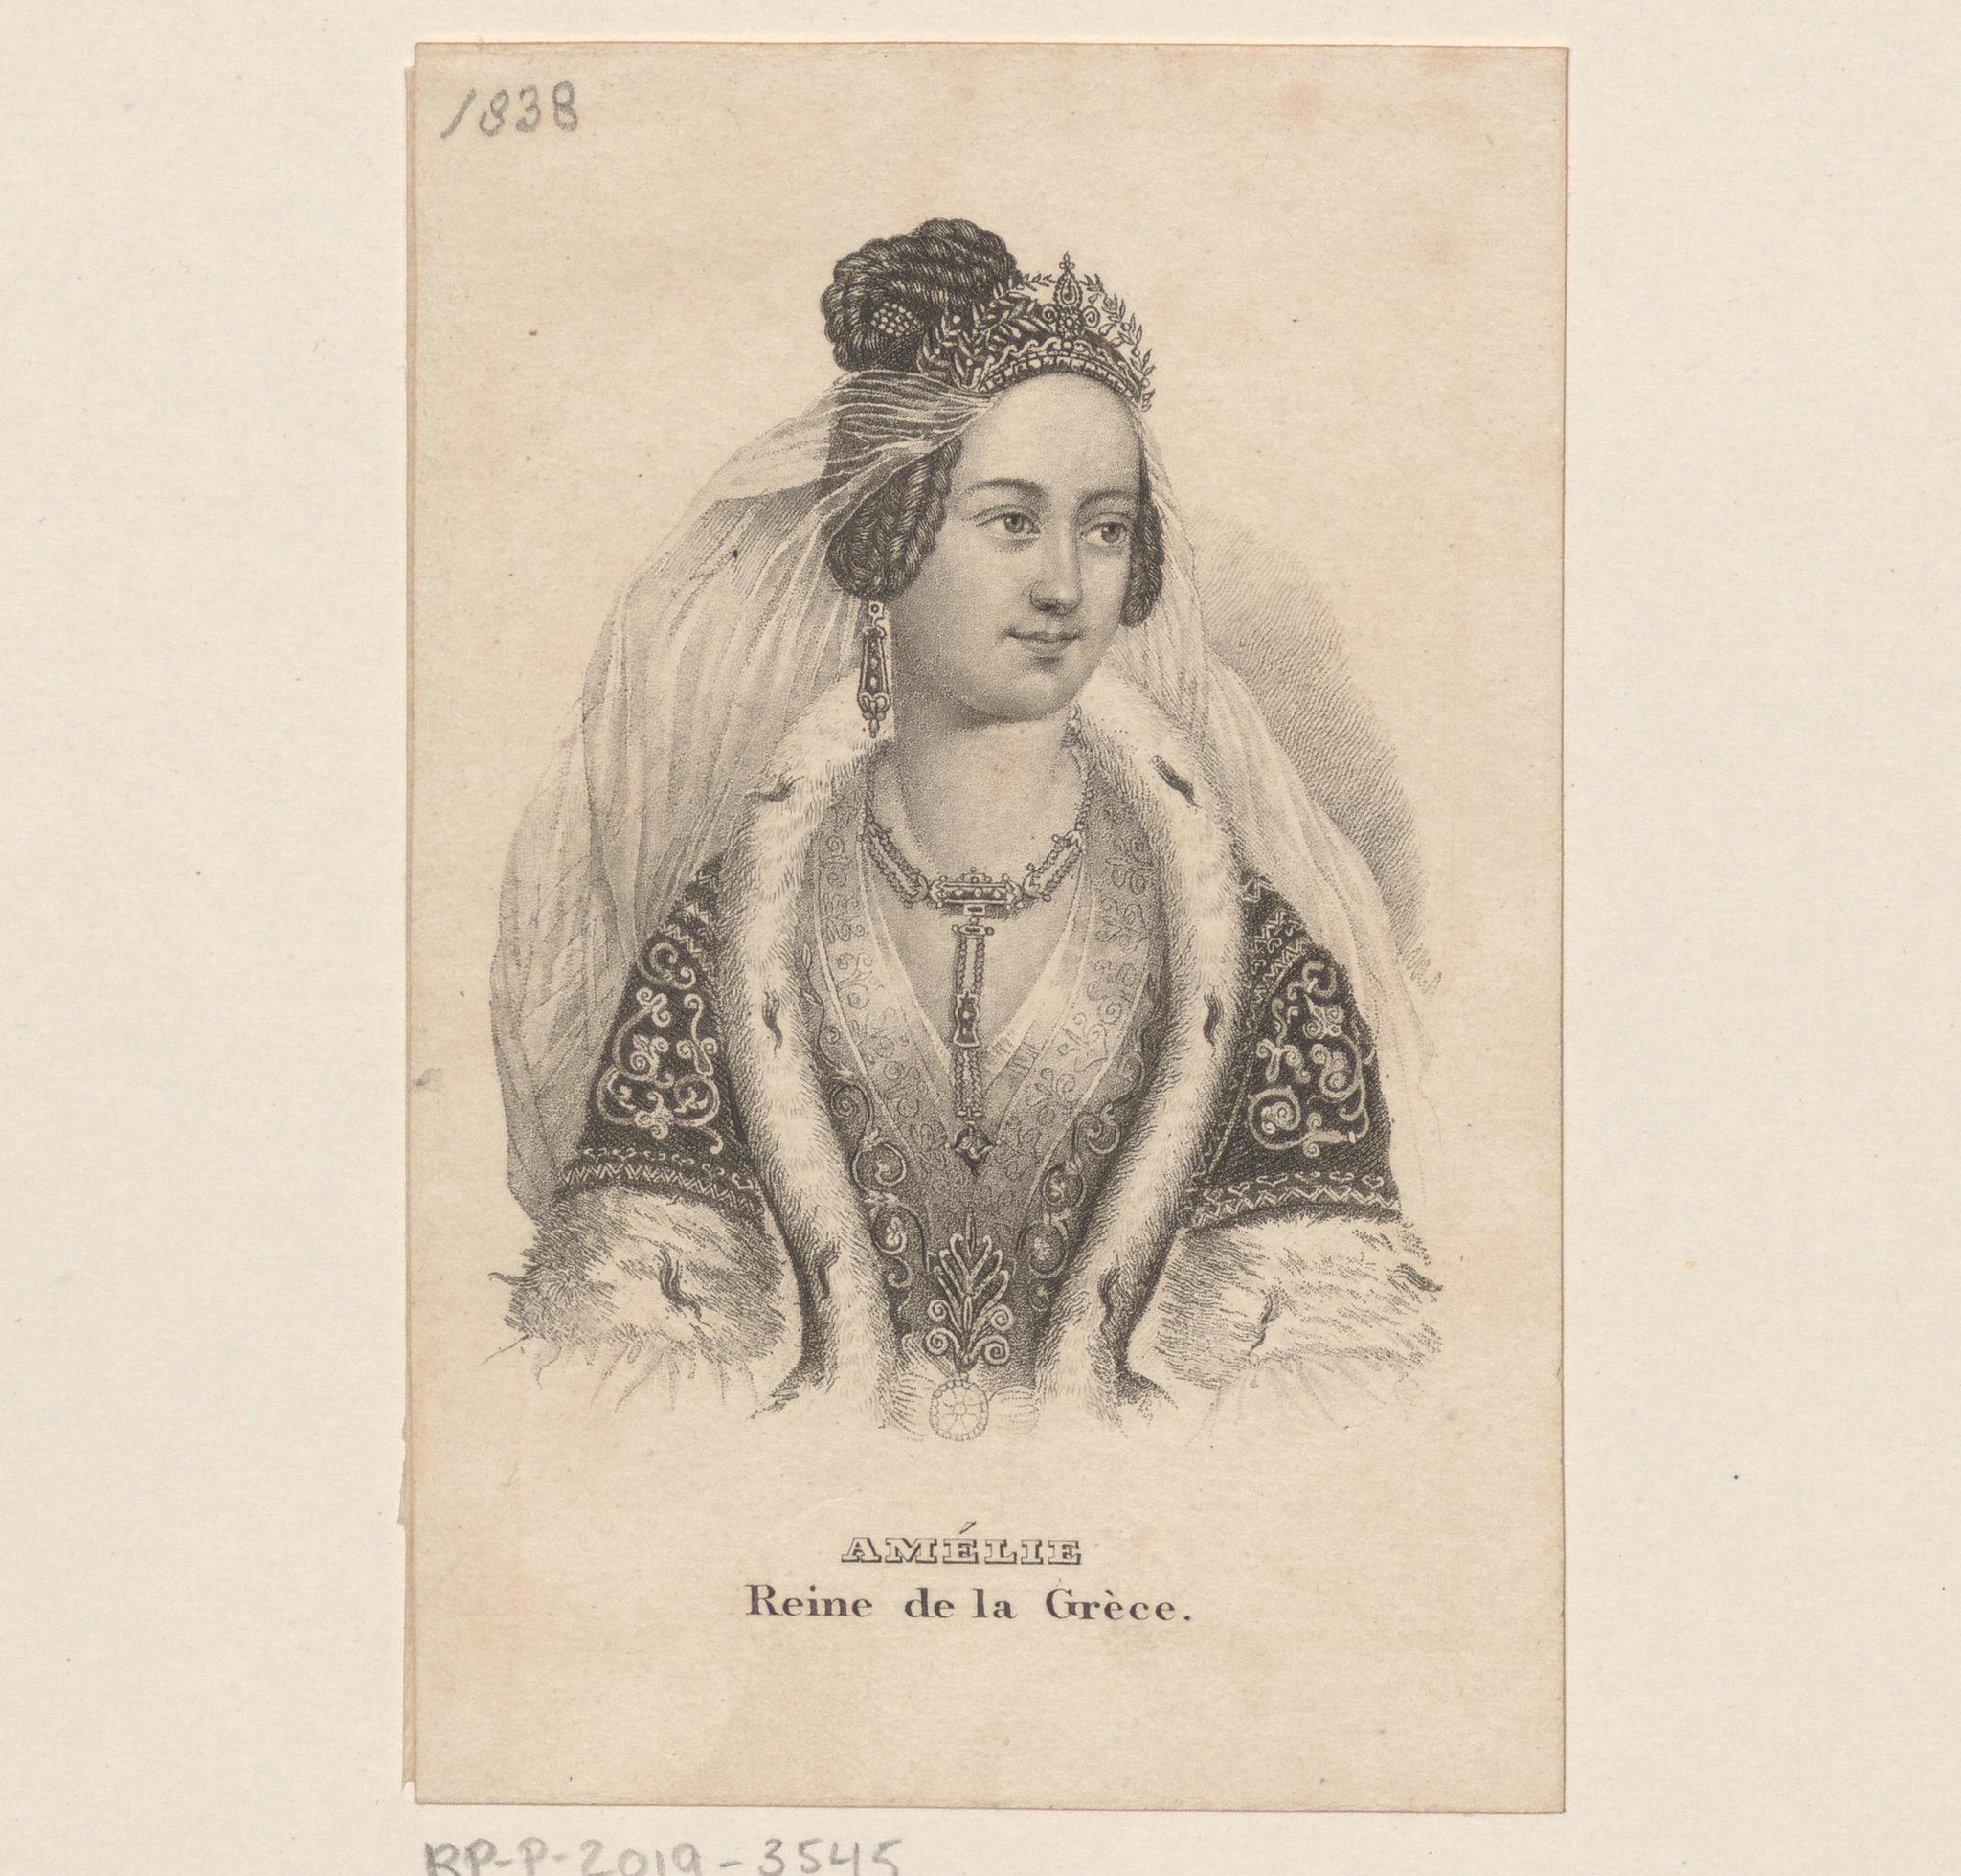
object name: print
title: Portret van Amalia van Oldenburg, koningin van Griekenland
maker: Anonymous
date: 1838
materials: paper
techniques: etching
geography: gotha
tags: historical persons - bb - woman, ruler, sovereign - bb - female ruler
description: Prent uit: Almanach de Gotha pour l'année 1838. Gotha: Justus Perthes, 1838.